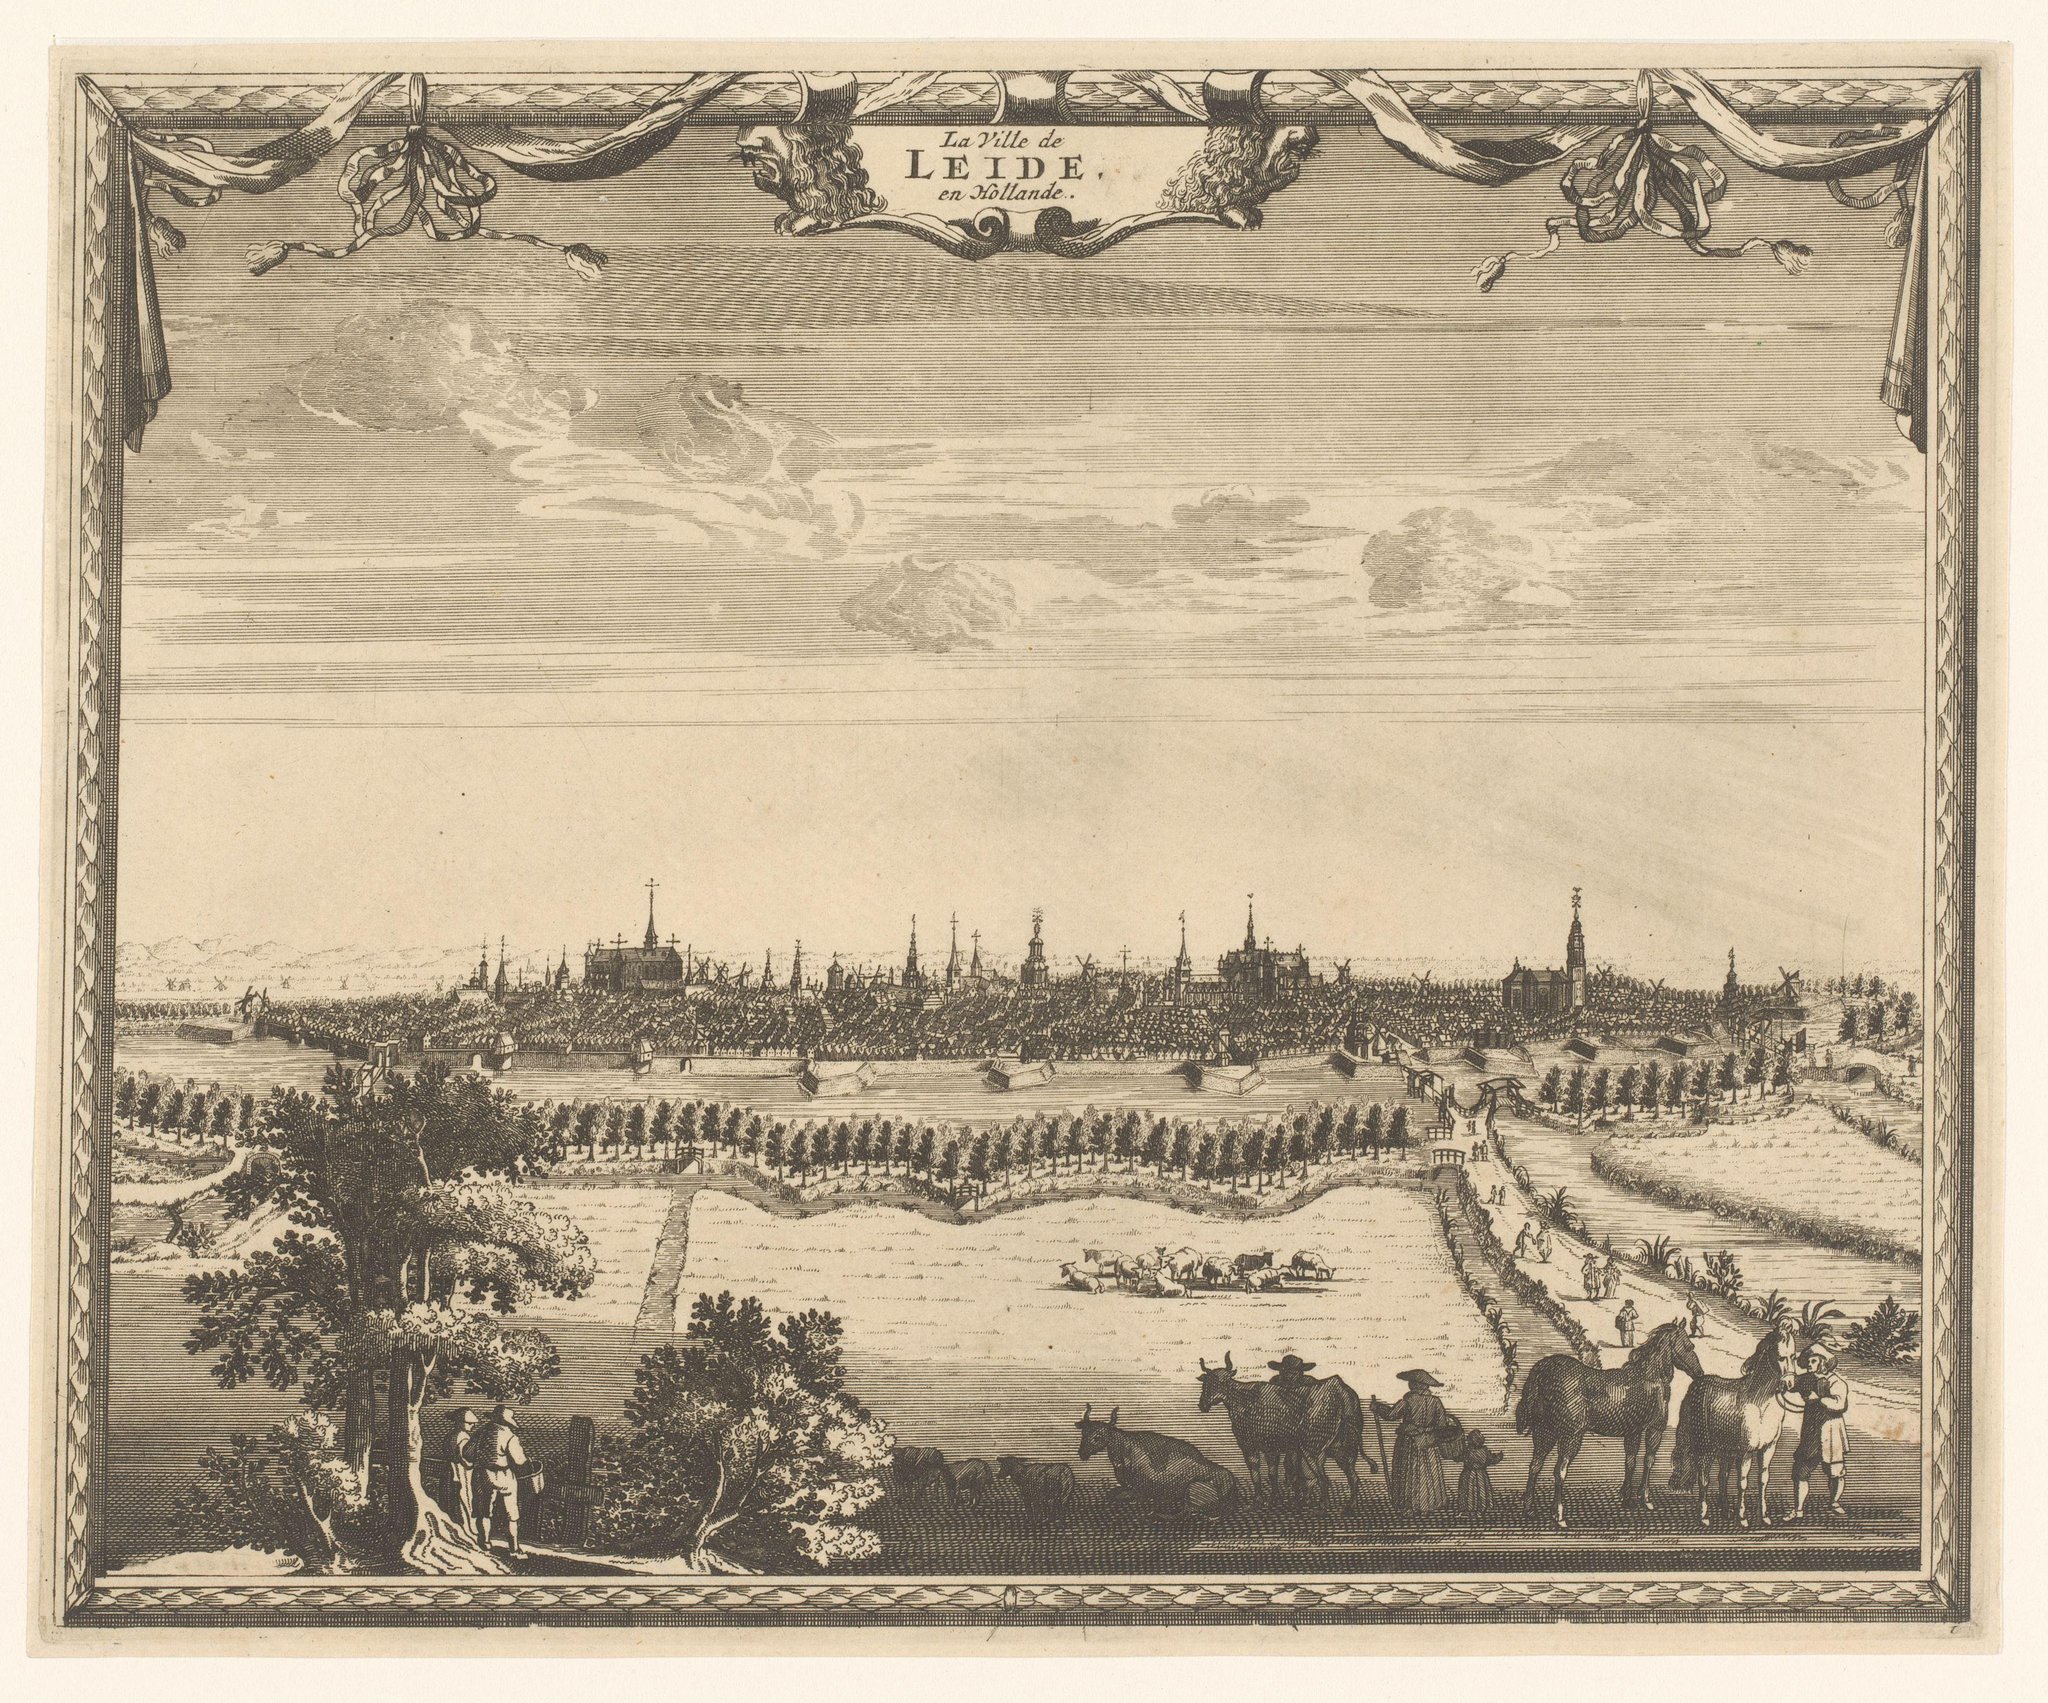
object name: print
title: La Ville de Leide, en Hollande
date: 1726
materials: paper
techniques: etching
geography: leiden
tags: prospect of city, town panorama, silhouette of city, leiden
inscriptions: watermark, collector's mark: Lugt 240, inscription: ‘Overvoorde 624.’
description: Behoort mogelijk tot de serie kopieën naar de prenten van Pieter Hendricksz. Schut, zie de serie in Hollstein dl. XXVI, p. 169-170, cat.nr. 33, waar dit gezicht niet vermeld wordt. Voor een eerdere staat zie RP-P-AO-10-12.